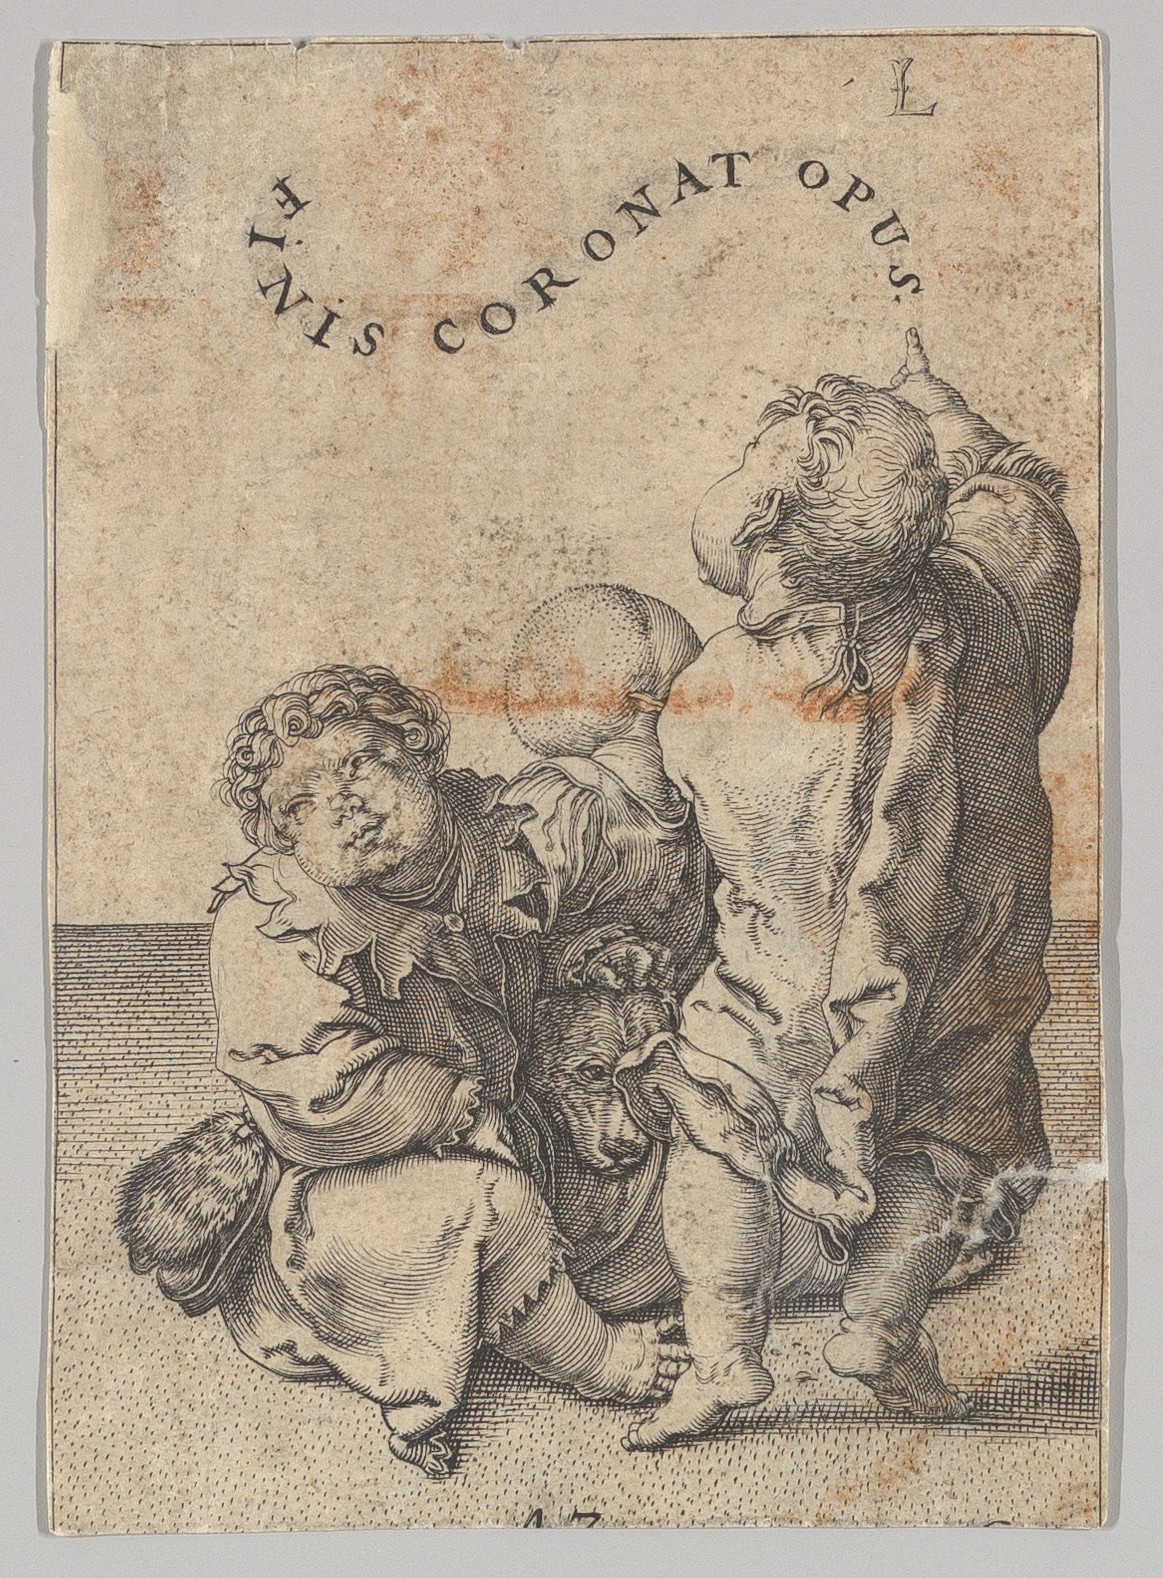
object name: print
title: Poet Virgil Suspended in a Basket, detail (copy)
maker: lucas van leyden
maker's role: artist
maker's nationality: netherlandish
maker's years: 1494-1533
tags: children,dogs